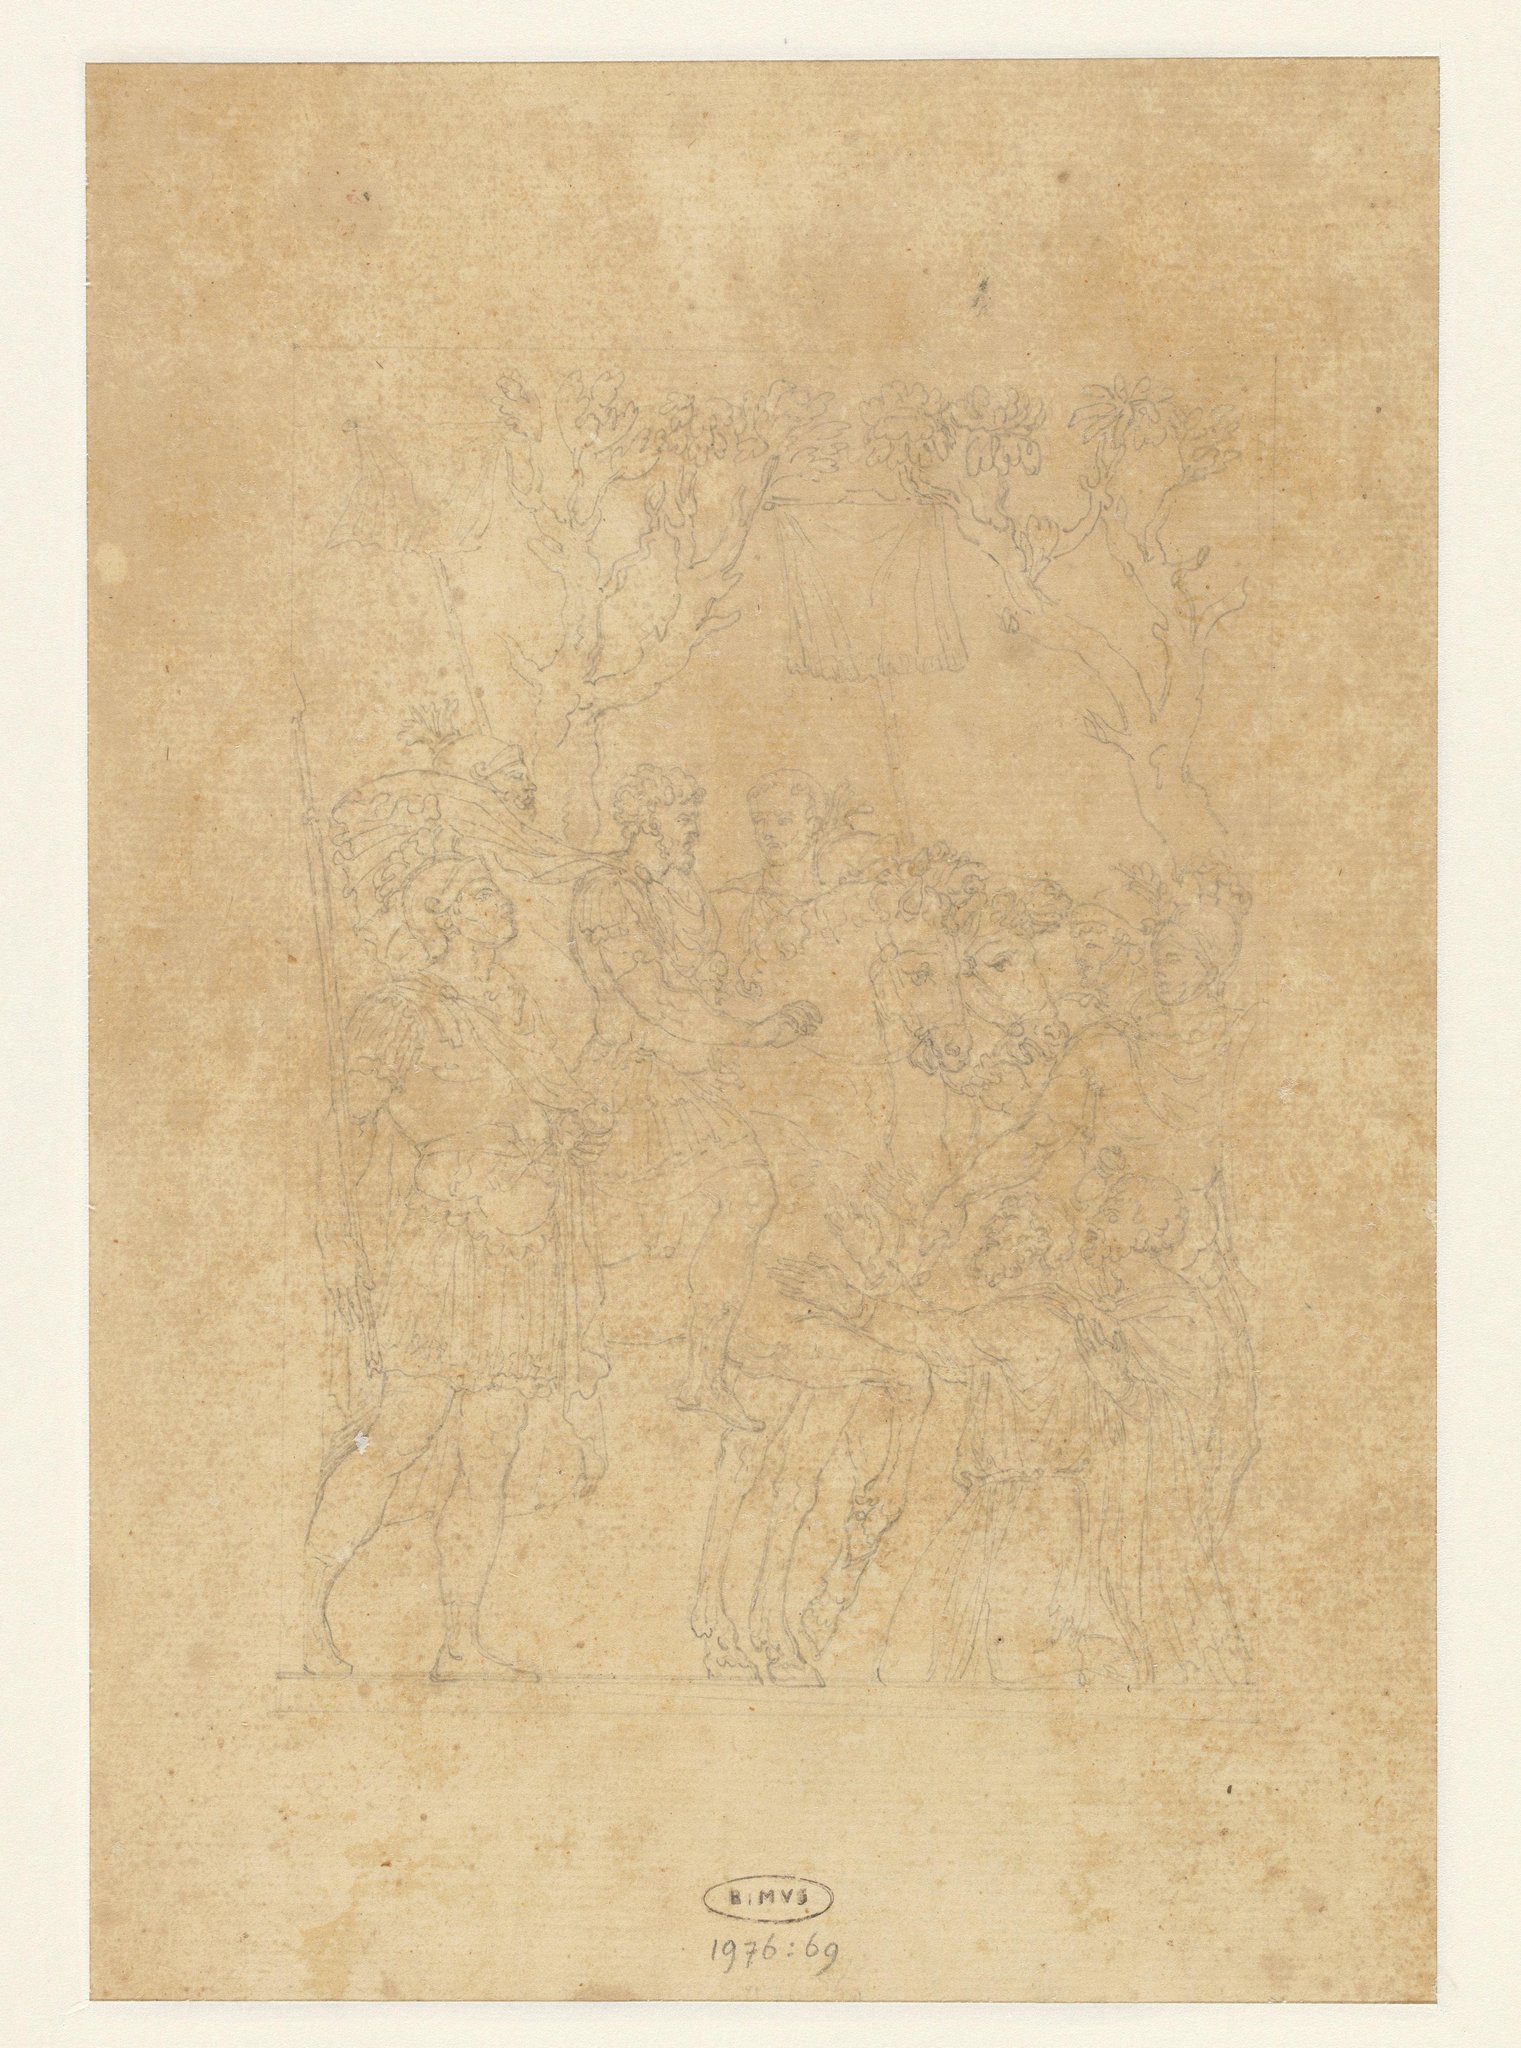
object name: drawing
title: Marcus Aurelius en de onderworpen Barbaren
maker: claude joseph vernet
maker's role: draughtsman, painter, print maker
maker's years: 1714-1789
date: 1724-1789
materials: graphite, paper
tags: rome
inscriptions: collector's mark, upper center: Lugt 2228